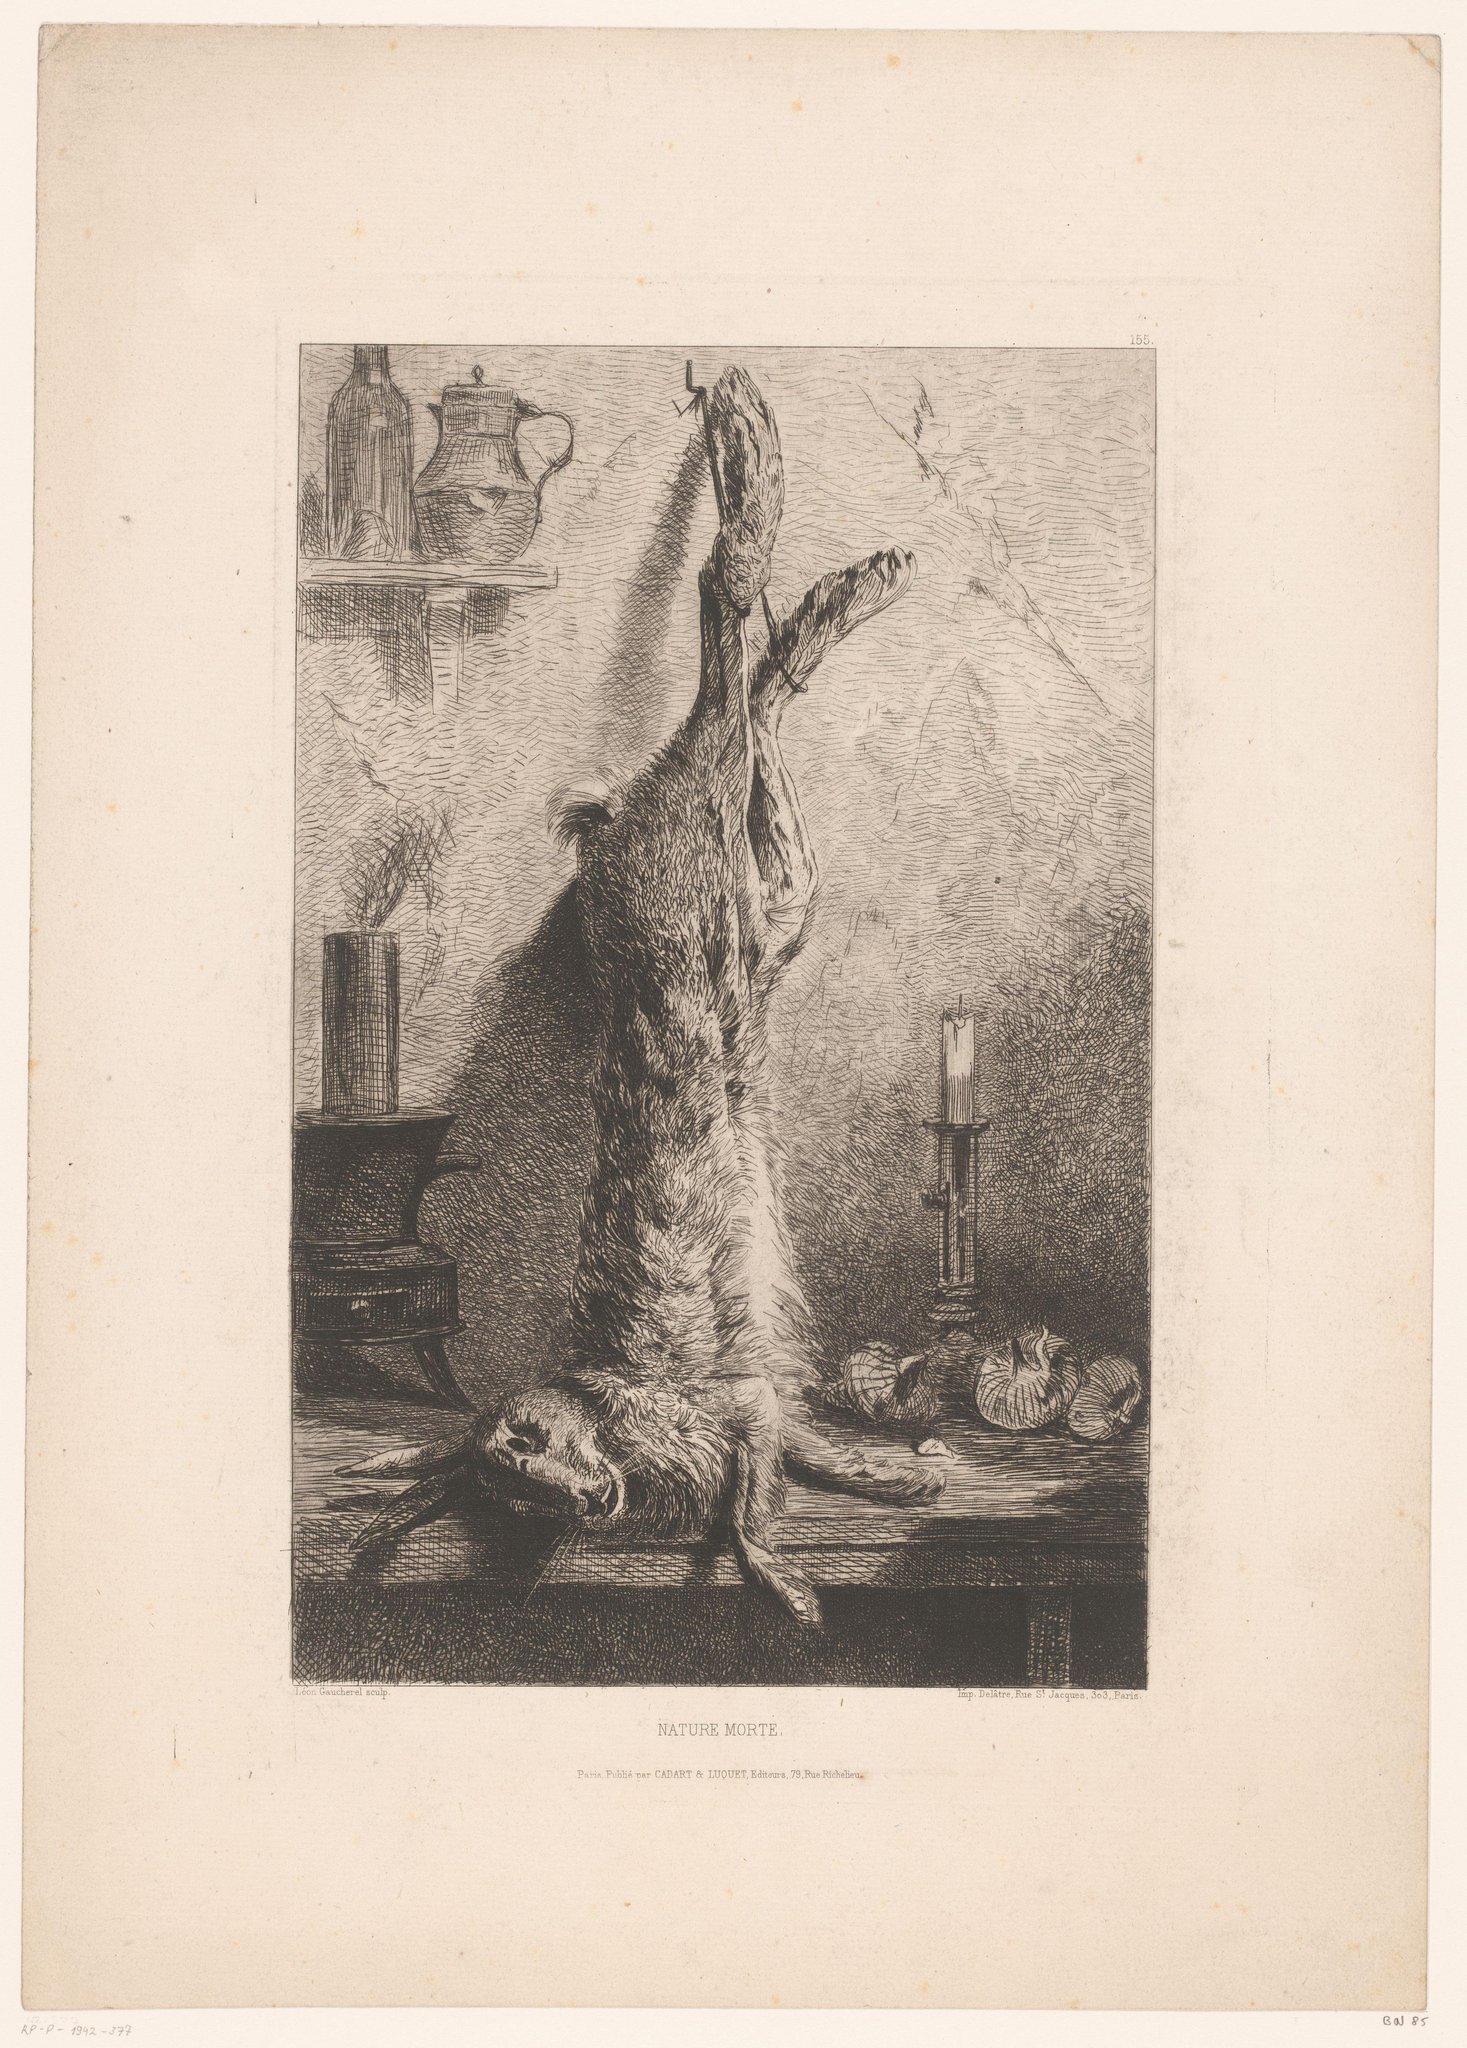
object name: print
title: Nature morte.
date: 1865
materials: paper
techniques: drypoint, etching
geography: paris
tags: hare-hunting, rabbit-hunting, candle, (non-fruit) products of plants or trees: onion, foodstuffs; still life of foodstuffs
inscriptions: collector's mark: Lugt 2760, collector's mark: Lugt 2228